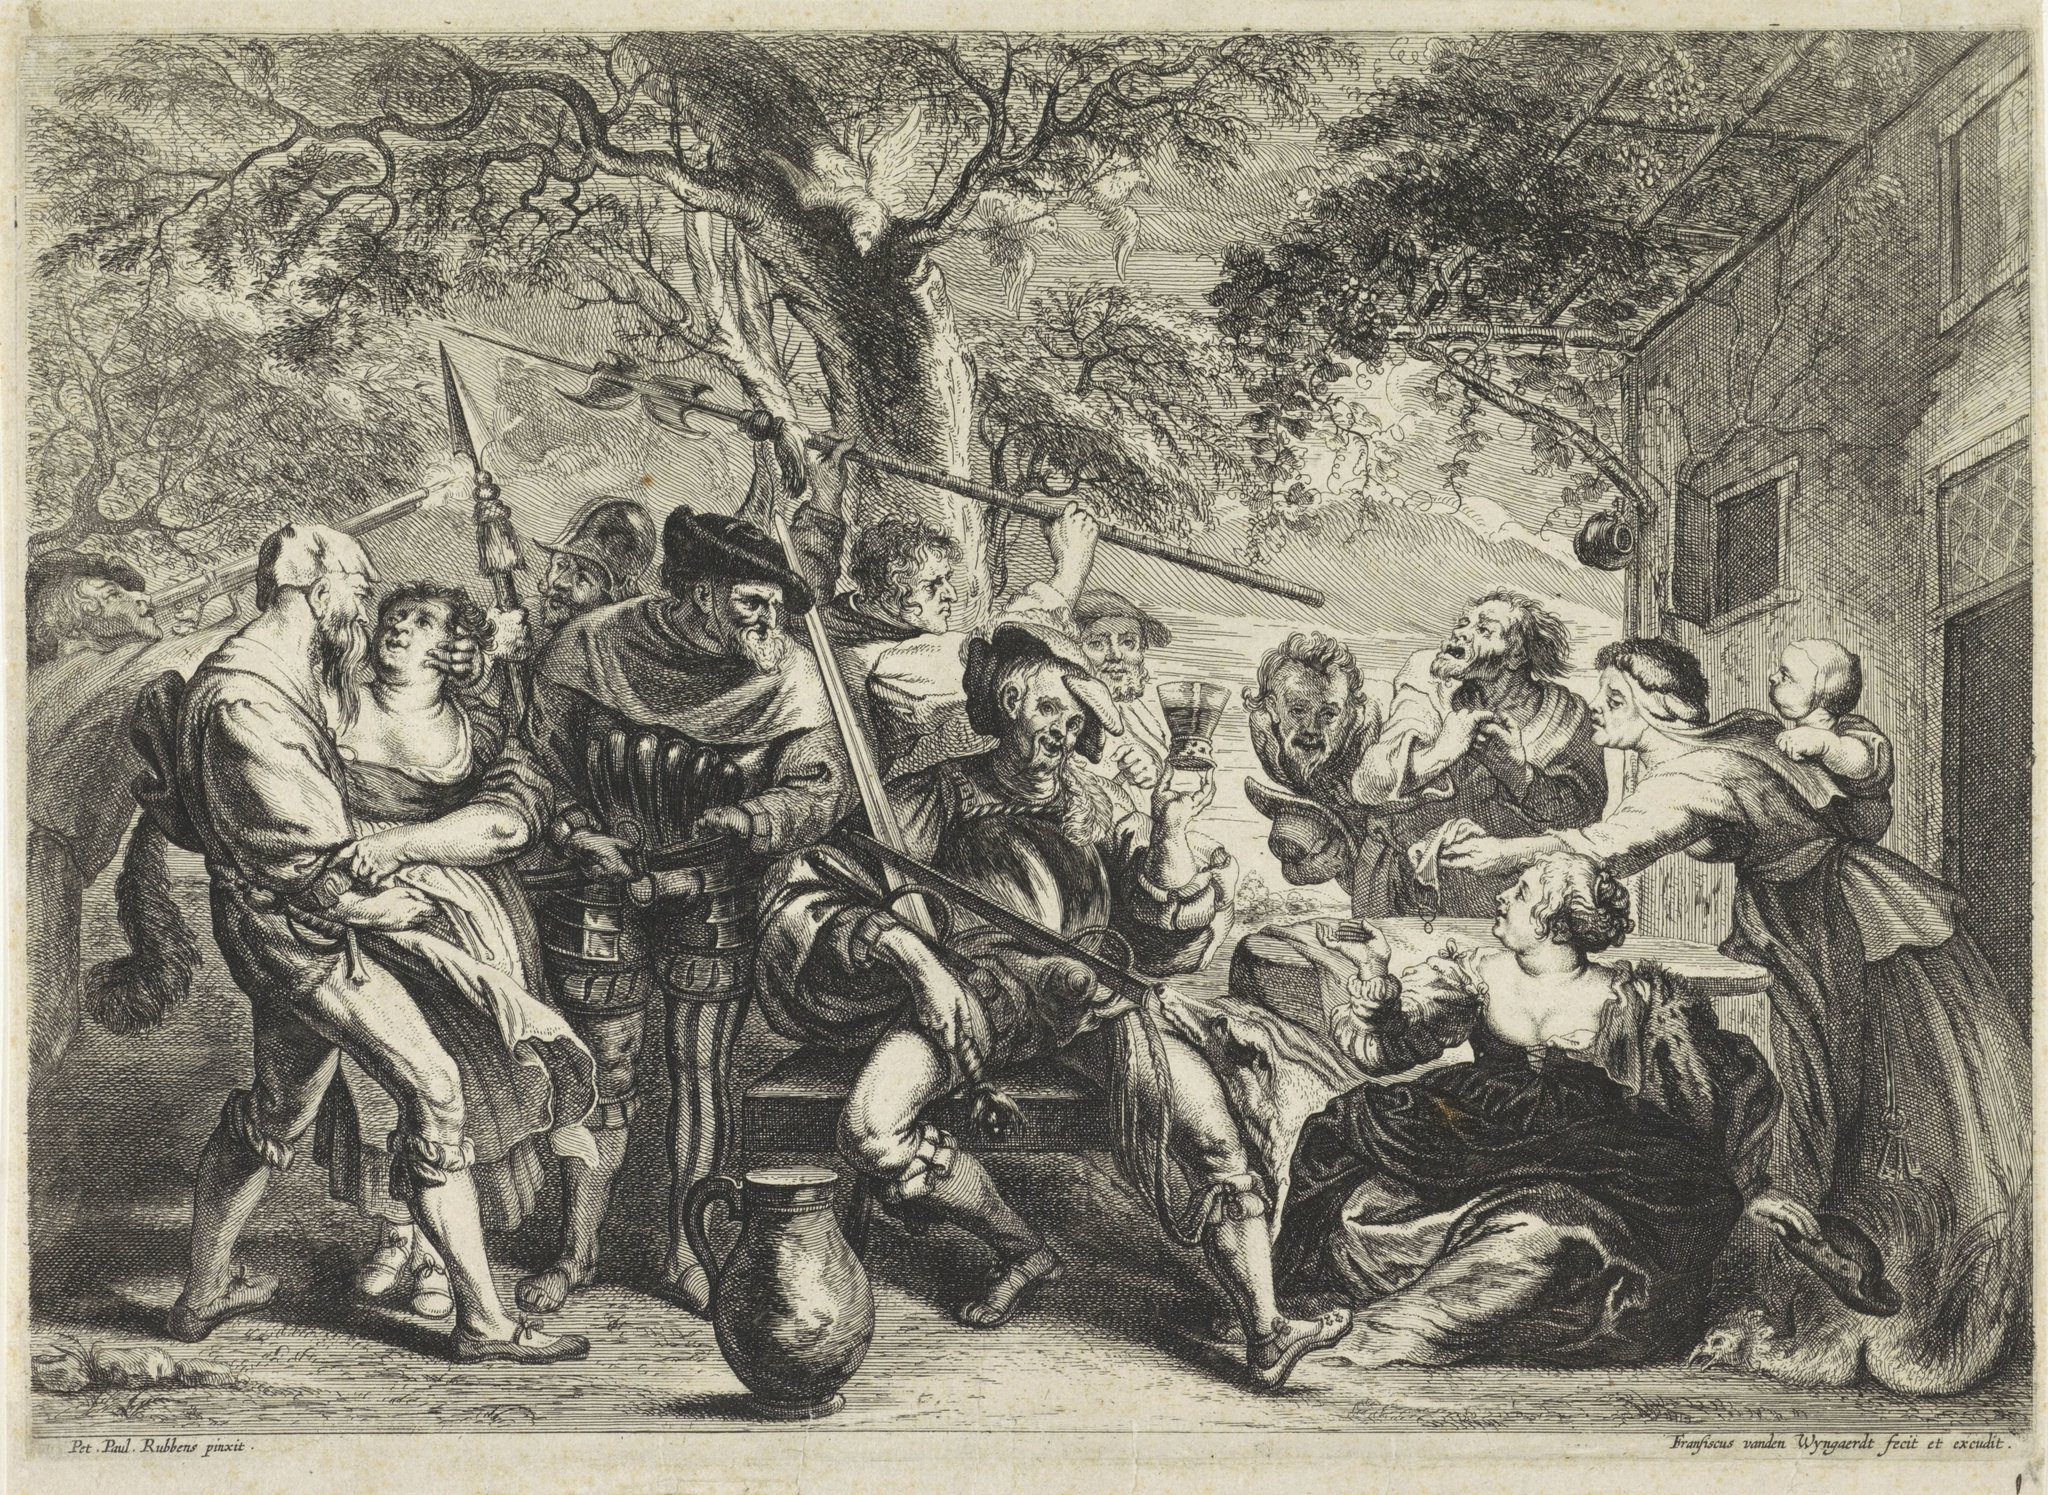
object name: print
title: Feestende boeren en soldaten voor een herberg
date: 1636-1679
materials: paper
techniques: engraving, etching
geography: antwerp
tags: bird hunting, container of glass: bottle, jar, vase, hotel, hostelry, inn, drunken brawl (usually peasants fighting in an inn)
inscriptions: number: ‘1’, collector's mark: Lugt 11, collector's mark: Lugt 10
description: Een gezelschap soldaten en boeren heeft zich verzameld voor een herberg. In het midden heft een man zijn glas. Aan zijn voeten staat een grote kan. Links schiet een soldaat op de vogels die in de boom zitten.